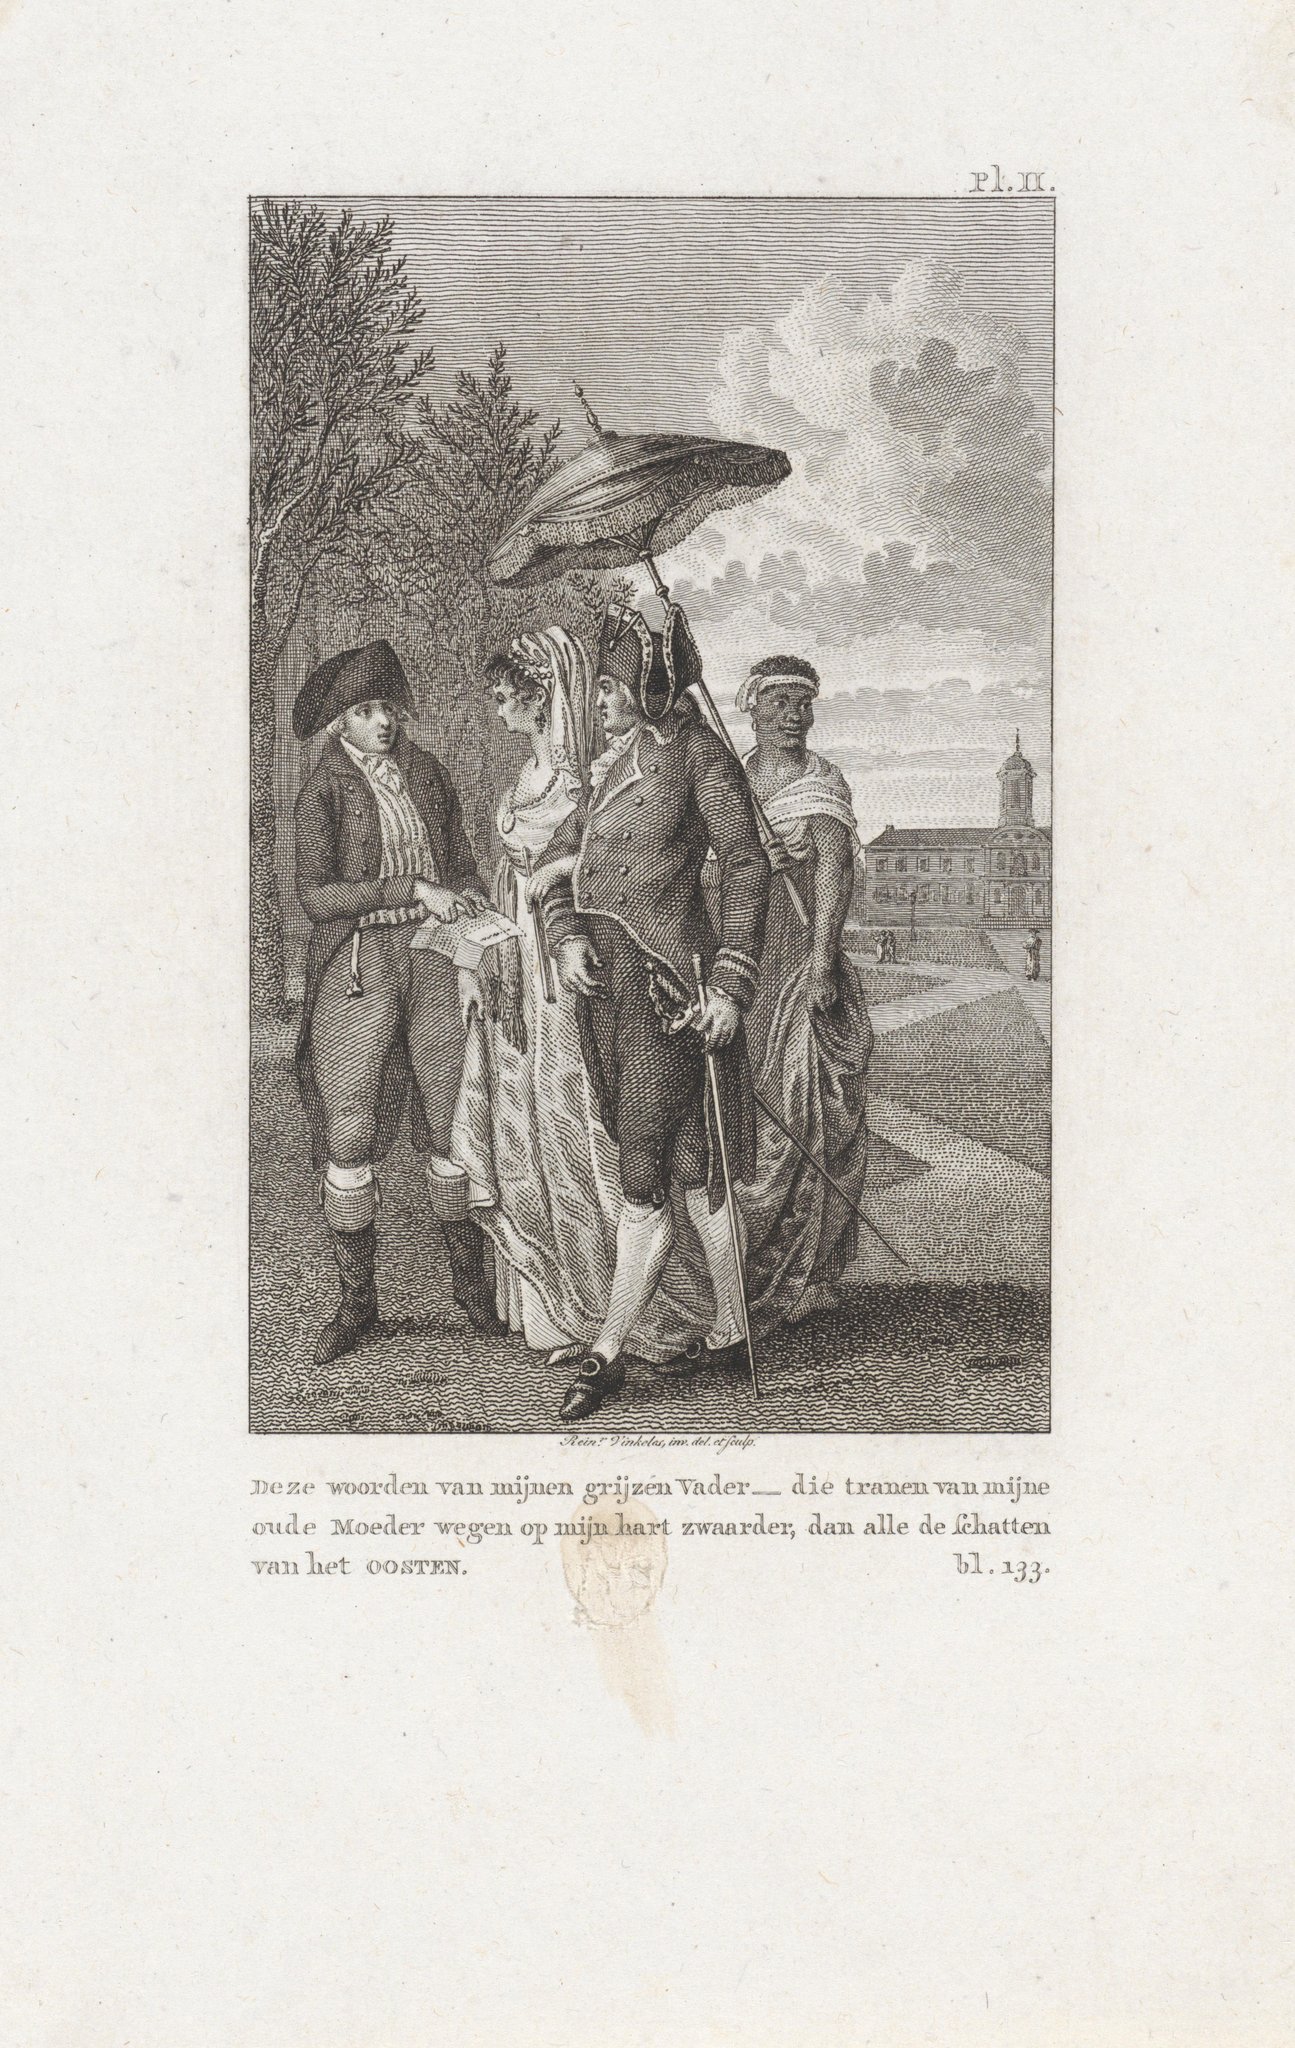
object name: print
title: Jakob en Hidde voeren een gesprek tijdens een wandeling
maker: reinier vinkeles (i)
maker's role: draughtsman, print maker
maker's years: 1741-1816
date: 1804-1805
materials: paper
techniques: engraving, etching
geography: amsterdam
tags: garden, letter, envelope, conversation, dialogue; conversation piece, waving farewell ~ departure on a journey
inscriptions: collector's mark: Lugt 240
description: Tijdens een wandeling vertelt Jakob aan Hidde dat hij terug zal gaan naar zijn Vaderland. Hij laat daarbij de brief van zijn vader zien. Hidde zet hierop twee stappen achteruit. Illustratie bij het verhaal Jakob ten Haaf.